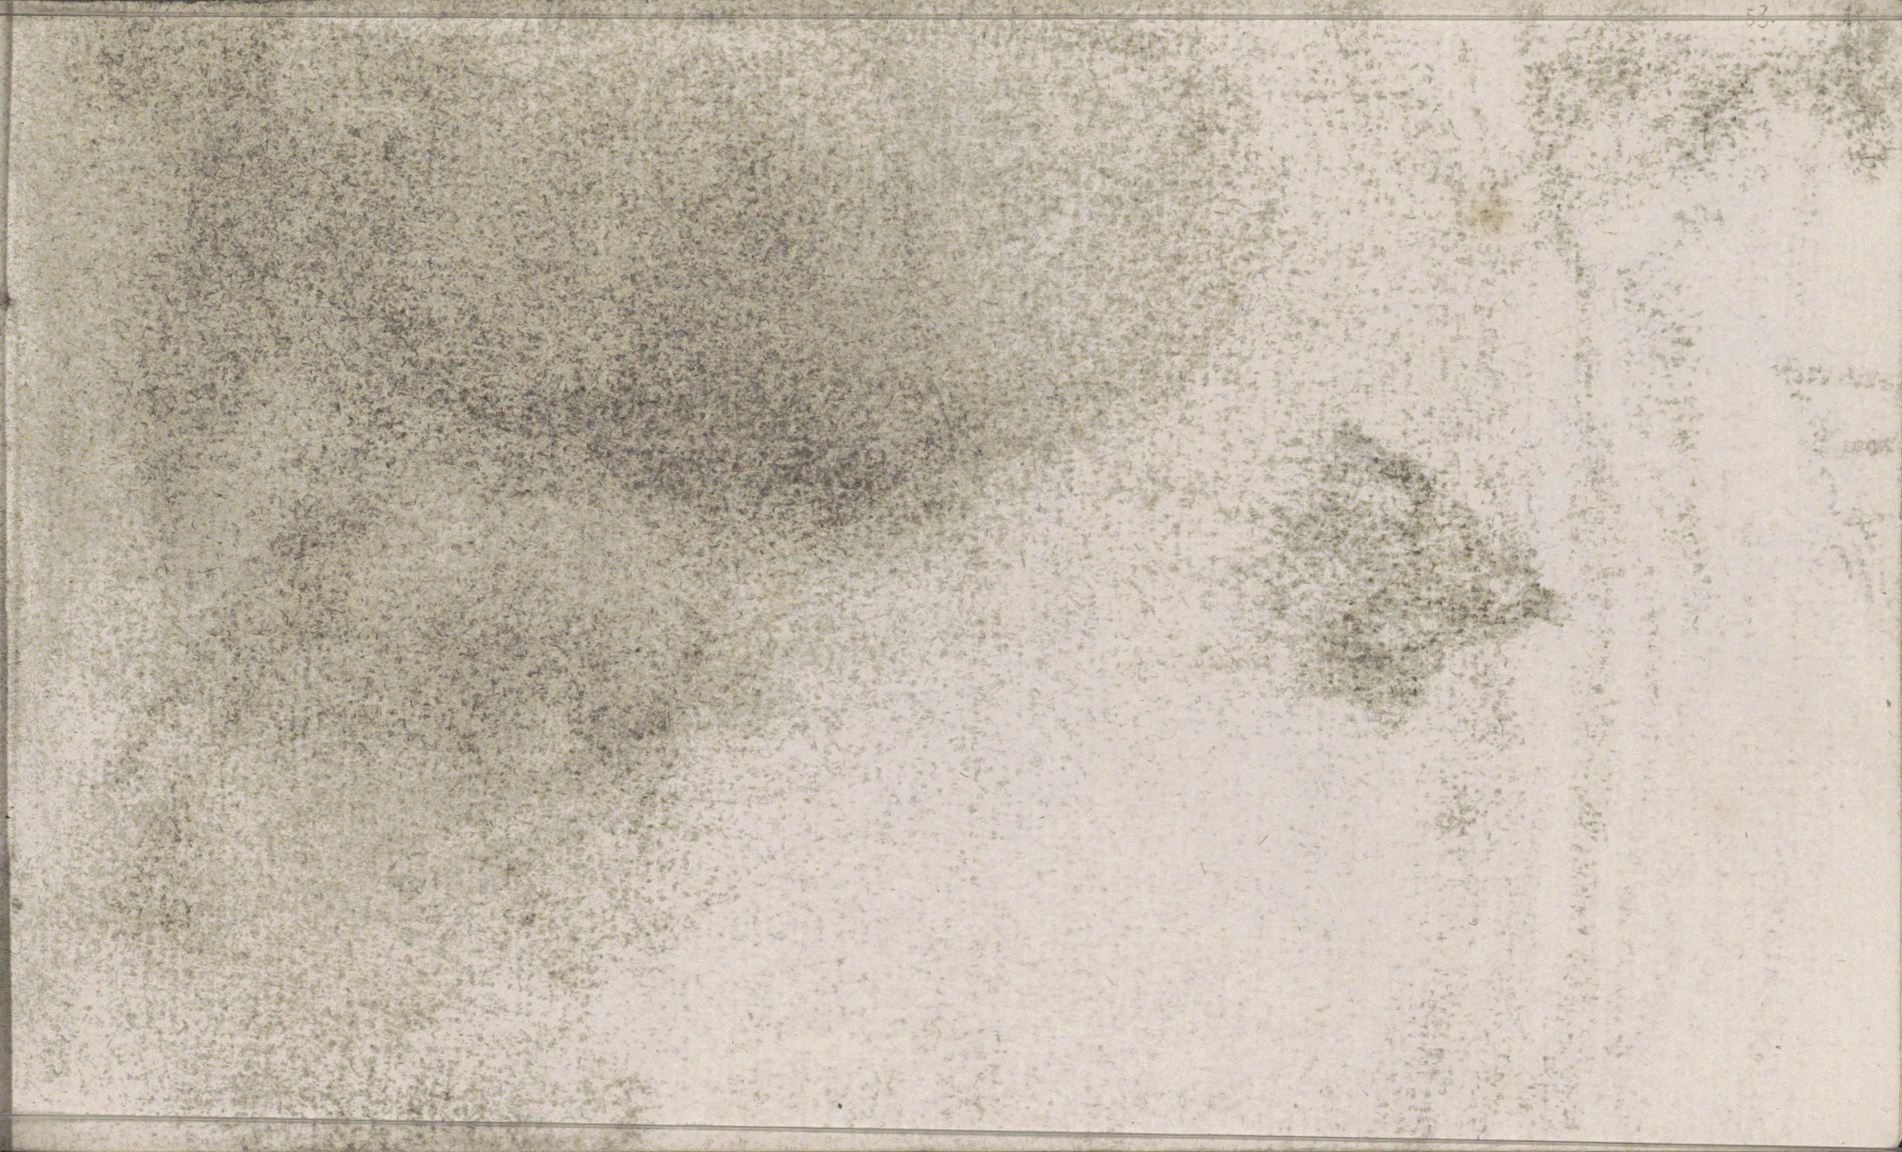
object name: sketchbook leaf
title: Abklatsch van de krijttekening op pagina 52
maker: isaac israels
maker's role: draughtsman, painter, print maker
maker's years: 1865-1934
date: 1875-1934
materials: paper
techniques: printmaking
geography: the hague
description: Pagina 53 uit schetsboek XLVIII met 62 pagina's.